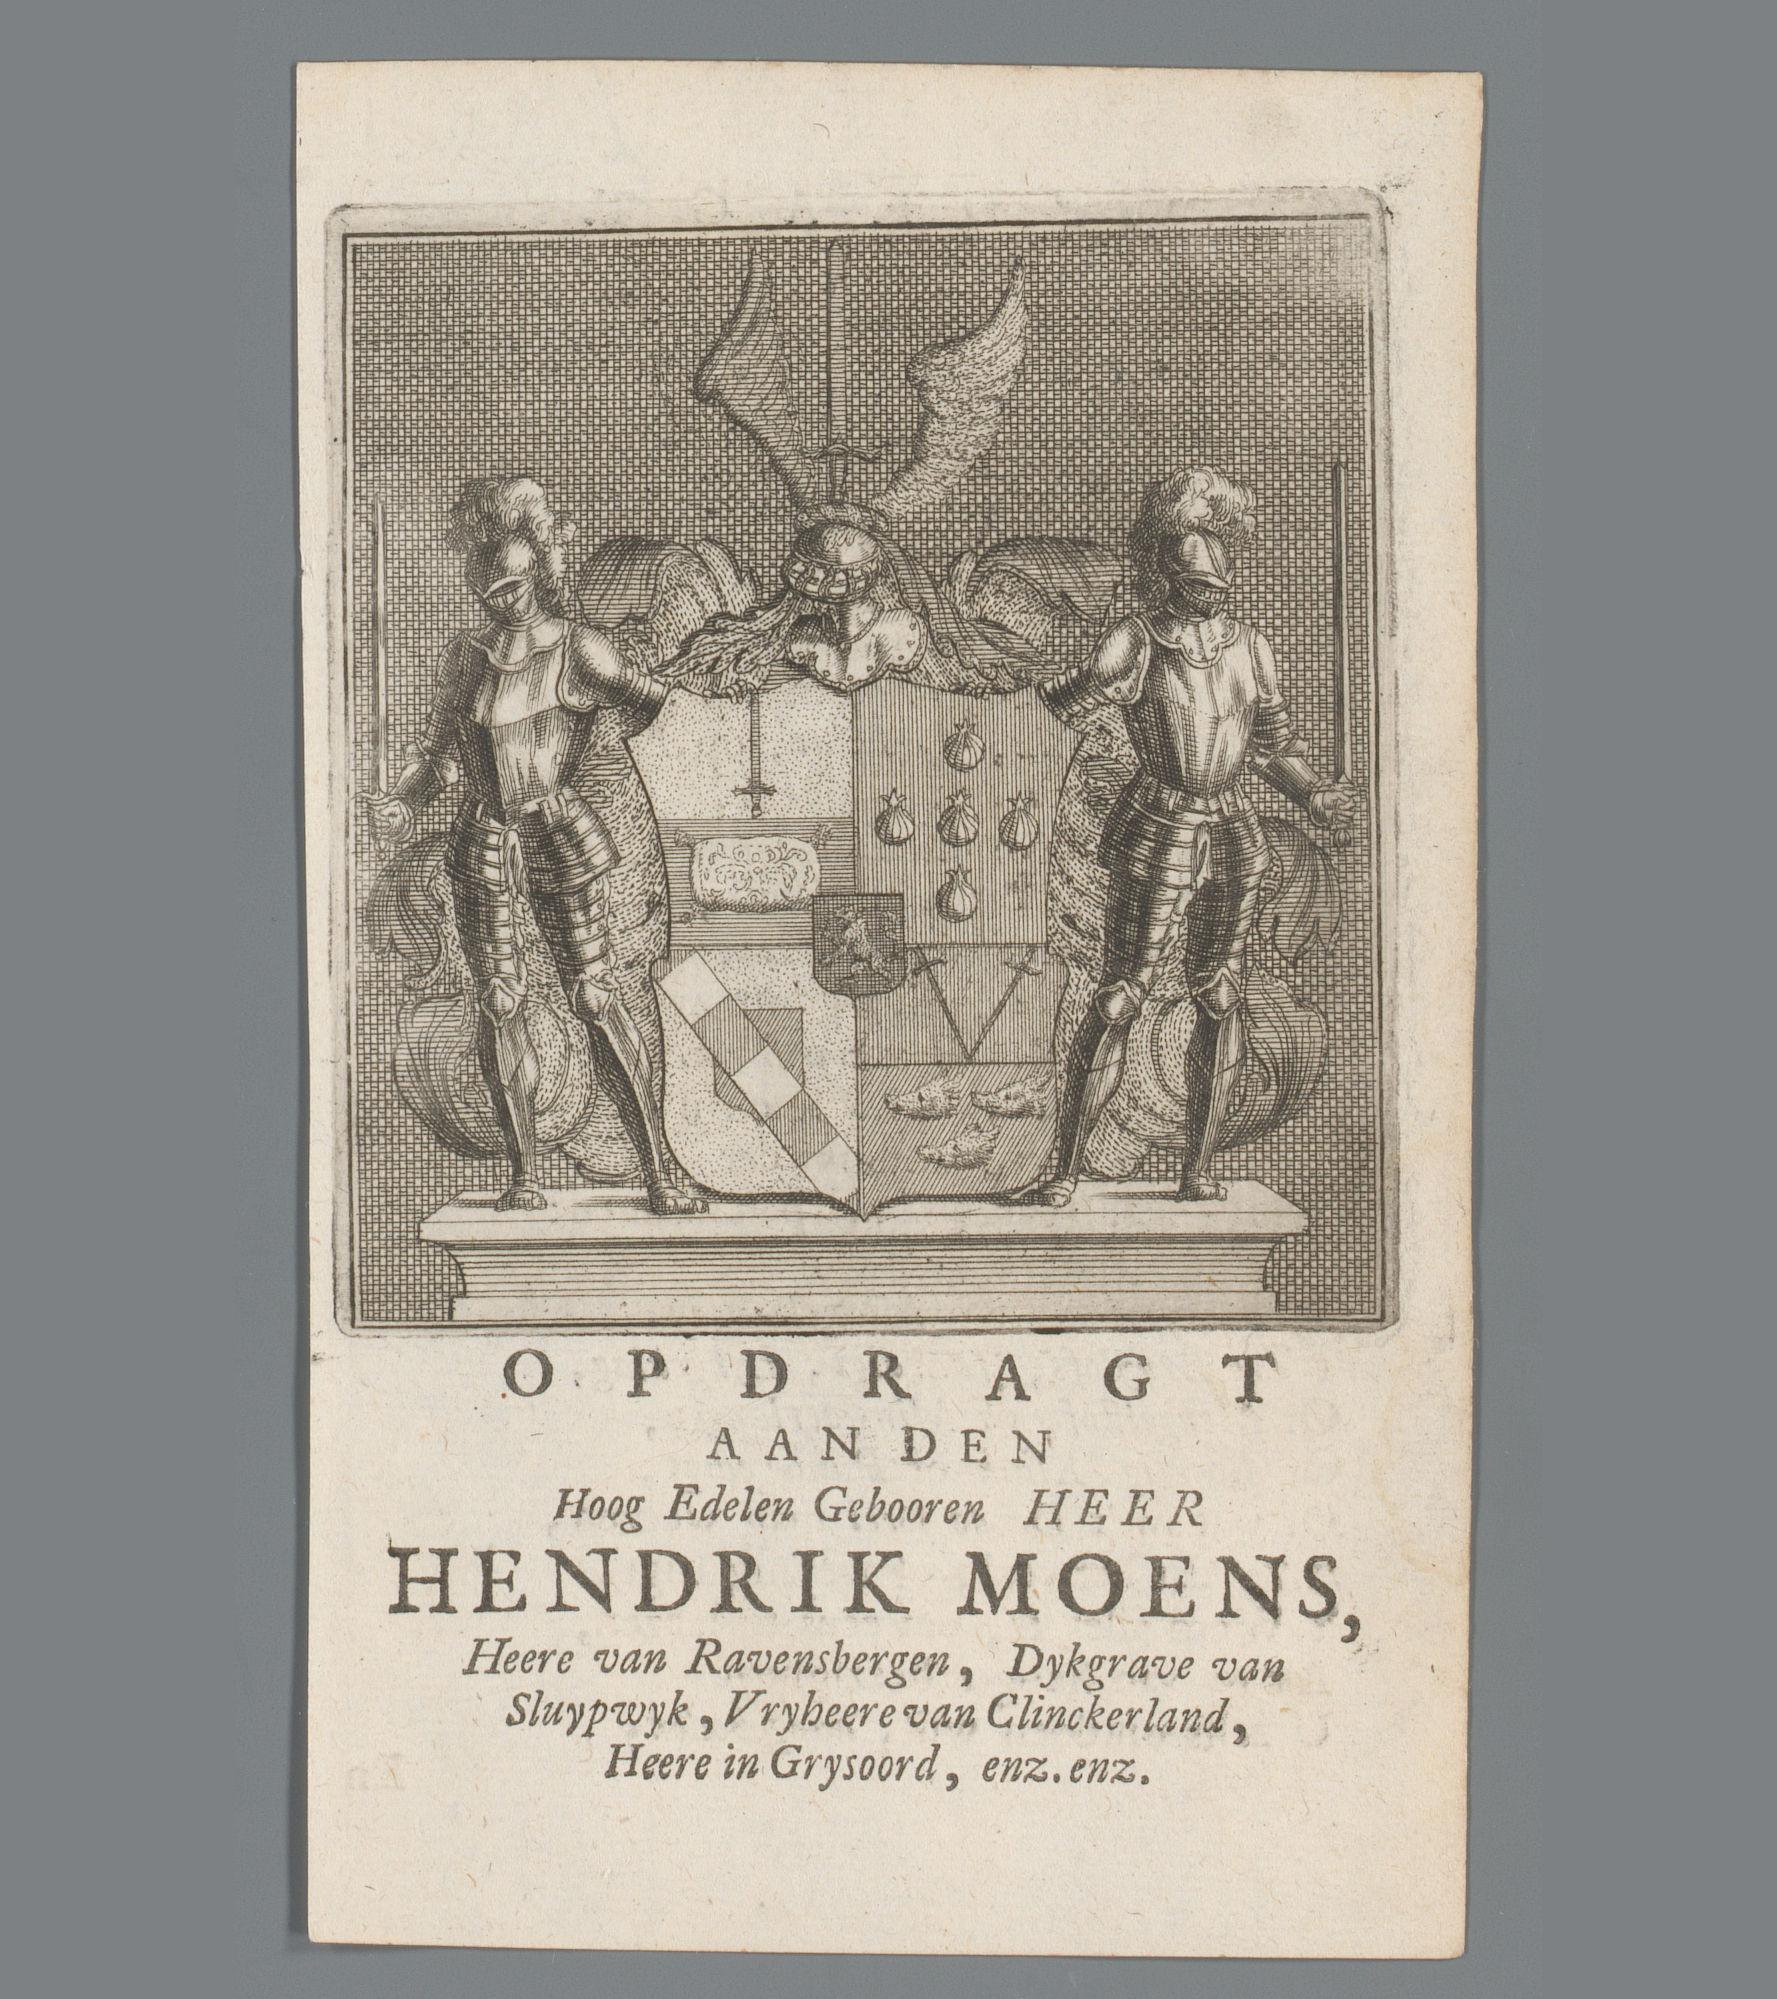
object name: book illustration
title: Wapenschild van Hendrik Moens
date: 1723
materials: paper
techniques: etching, letterpress printing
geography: amsterdam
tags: netherlands, earl, armour, armorial bearing, heraldry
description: Prent uit: Leuve, Roeland van. Mengelwerken. Amsterdam: Jacobus Verheyde, 1723, dl. 3.